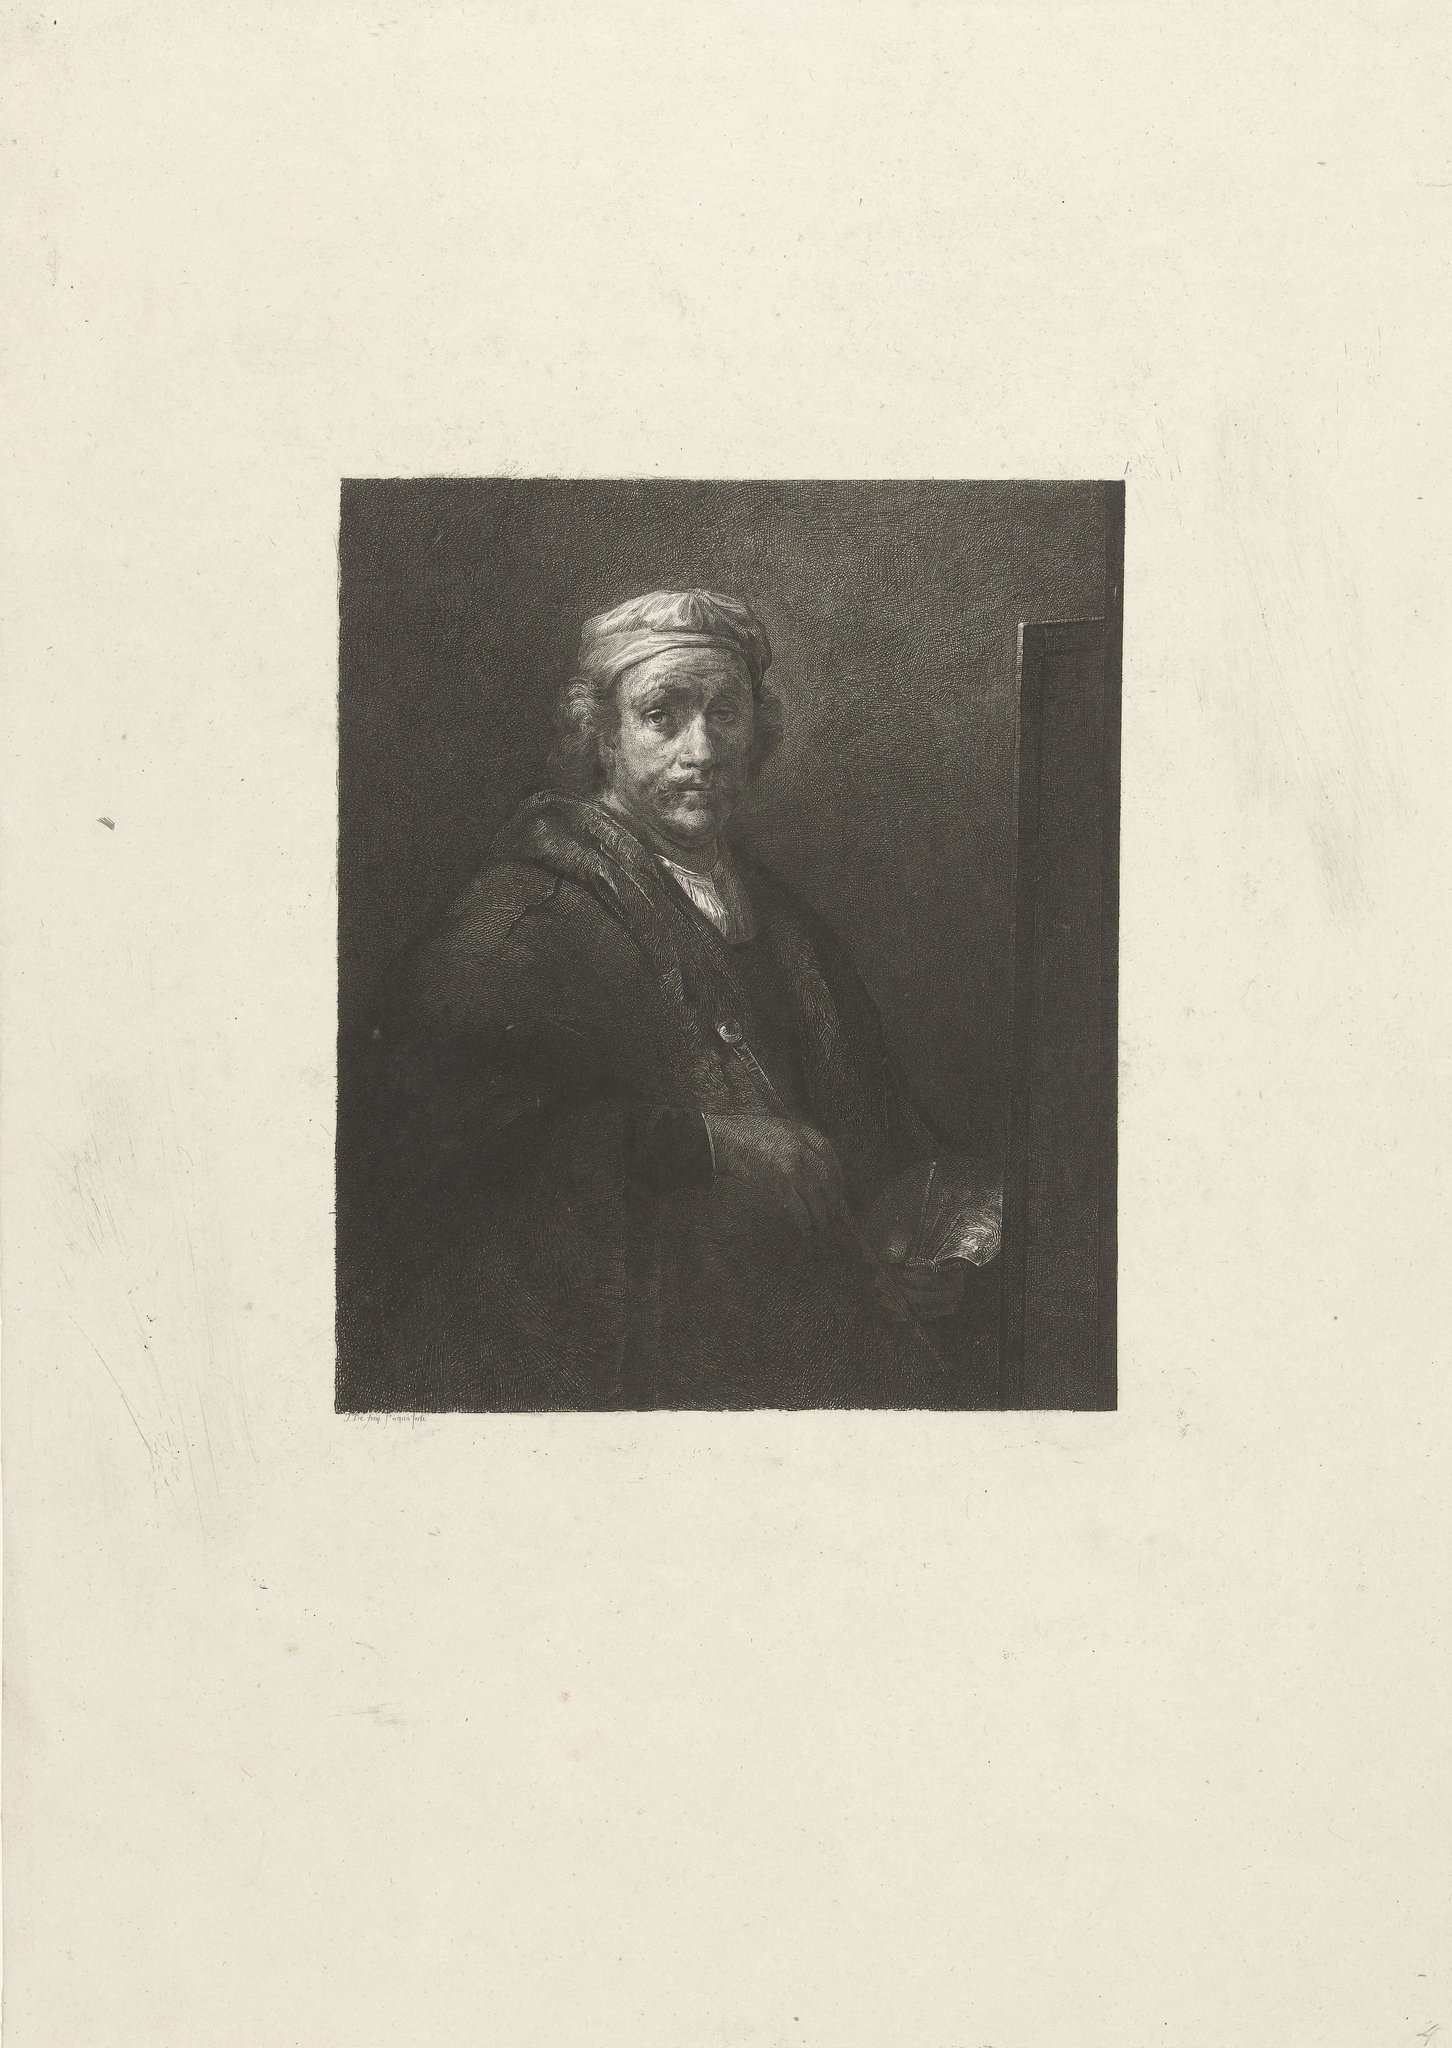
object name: print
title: Portret van Rembrandt van Rijn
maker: johannes pieter de frey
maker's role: draughtsman, print maker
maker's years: 1770-1834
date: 1780-1834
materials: paper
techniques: etching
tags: leiden, amsterdam, painter, print maker, draughtsman, rembrandt van rijn, portrait, self-portrait of artist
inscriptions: collector's mark: Lugt 12, number: ‘4’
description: Portret van Rembrandt van Rijn staande voor zijn schildersezel. Heupstuk, naar rechts. Op het hoofd een platte hoed, in zijn handen een palet met penselen en een schilderstok.